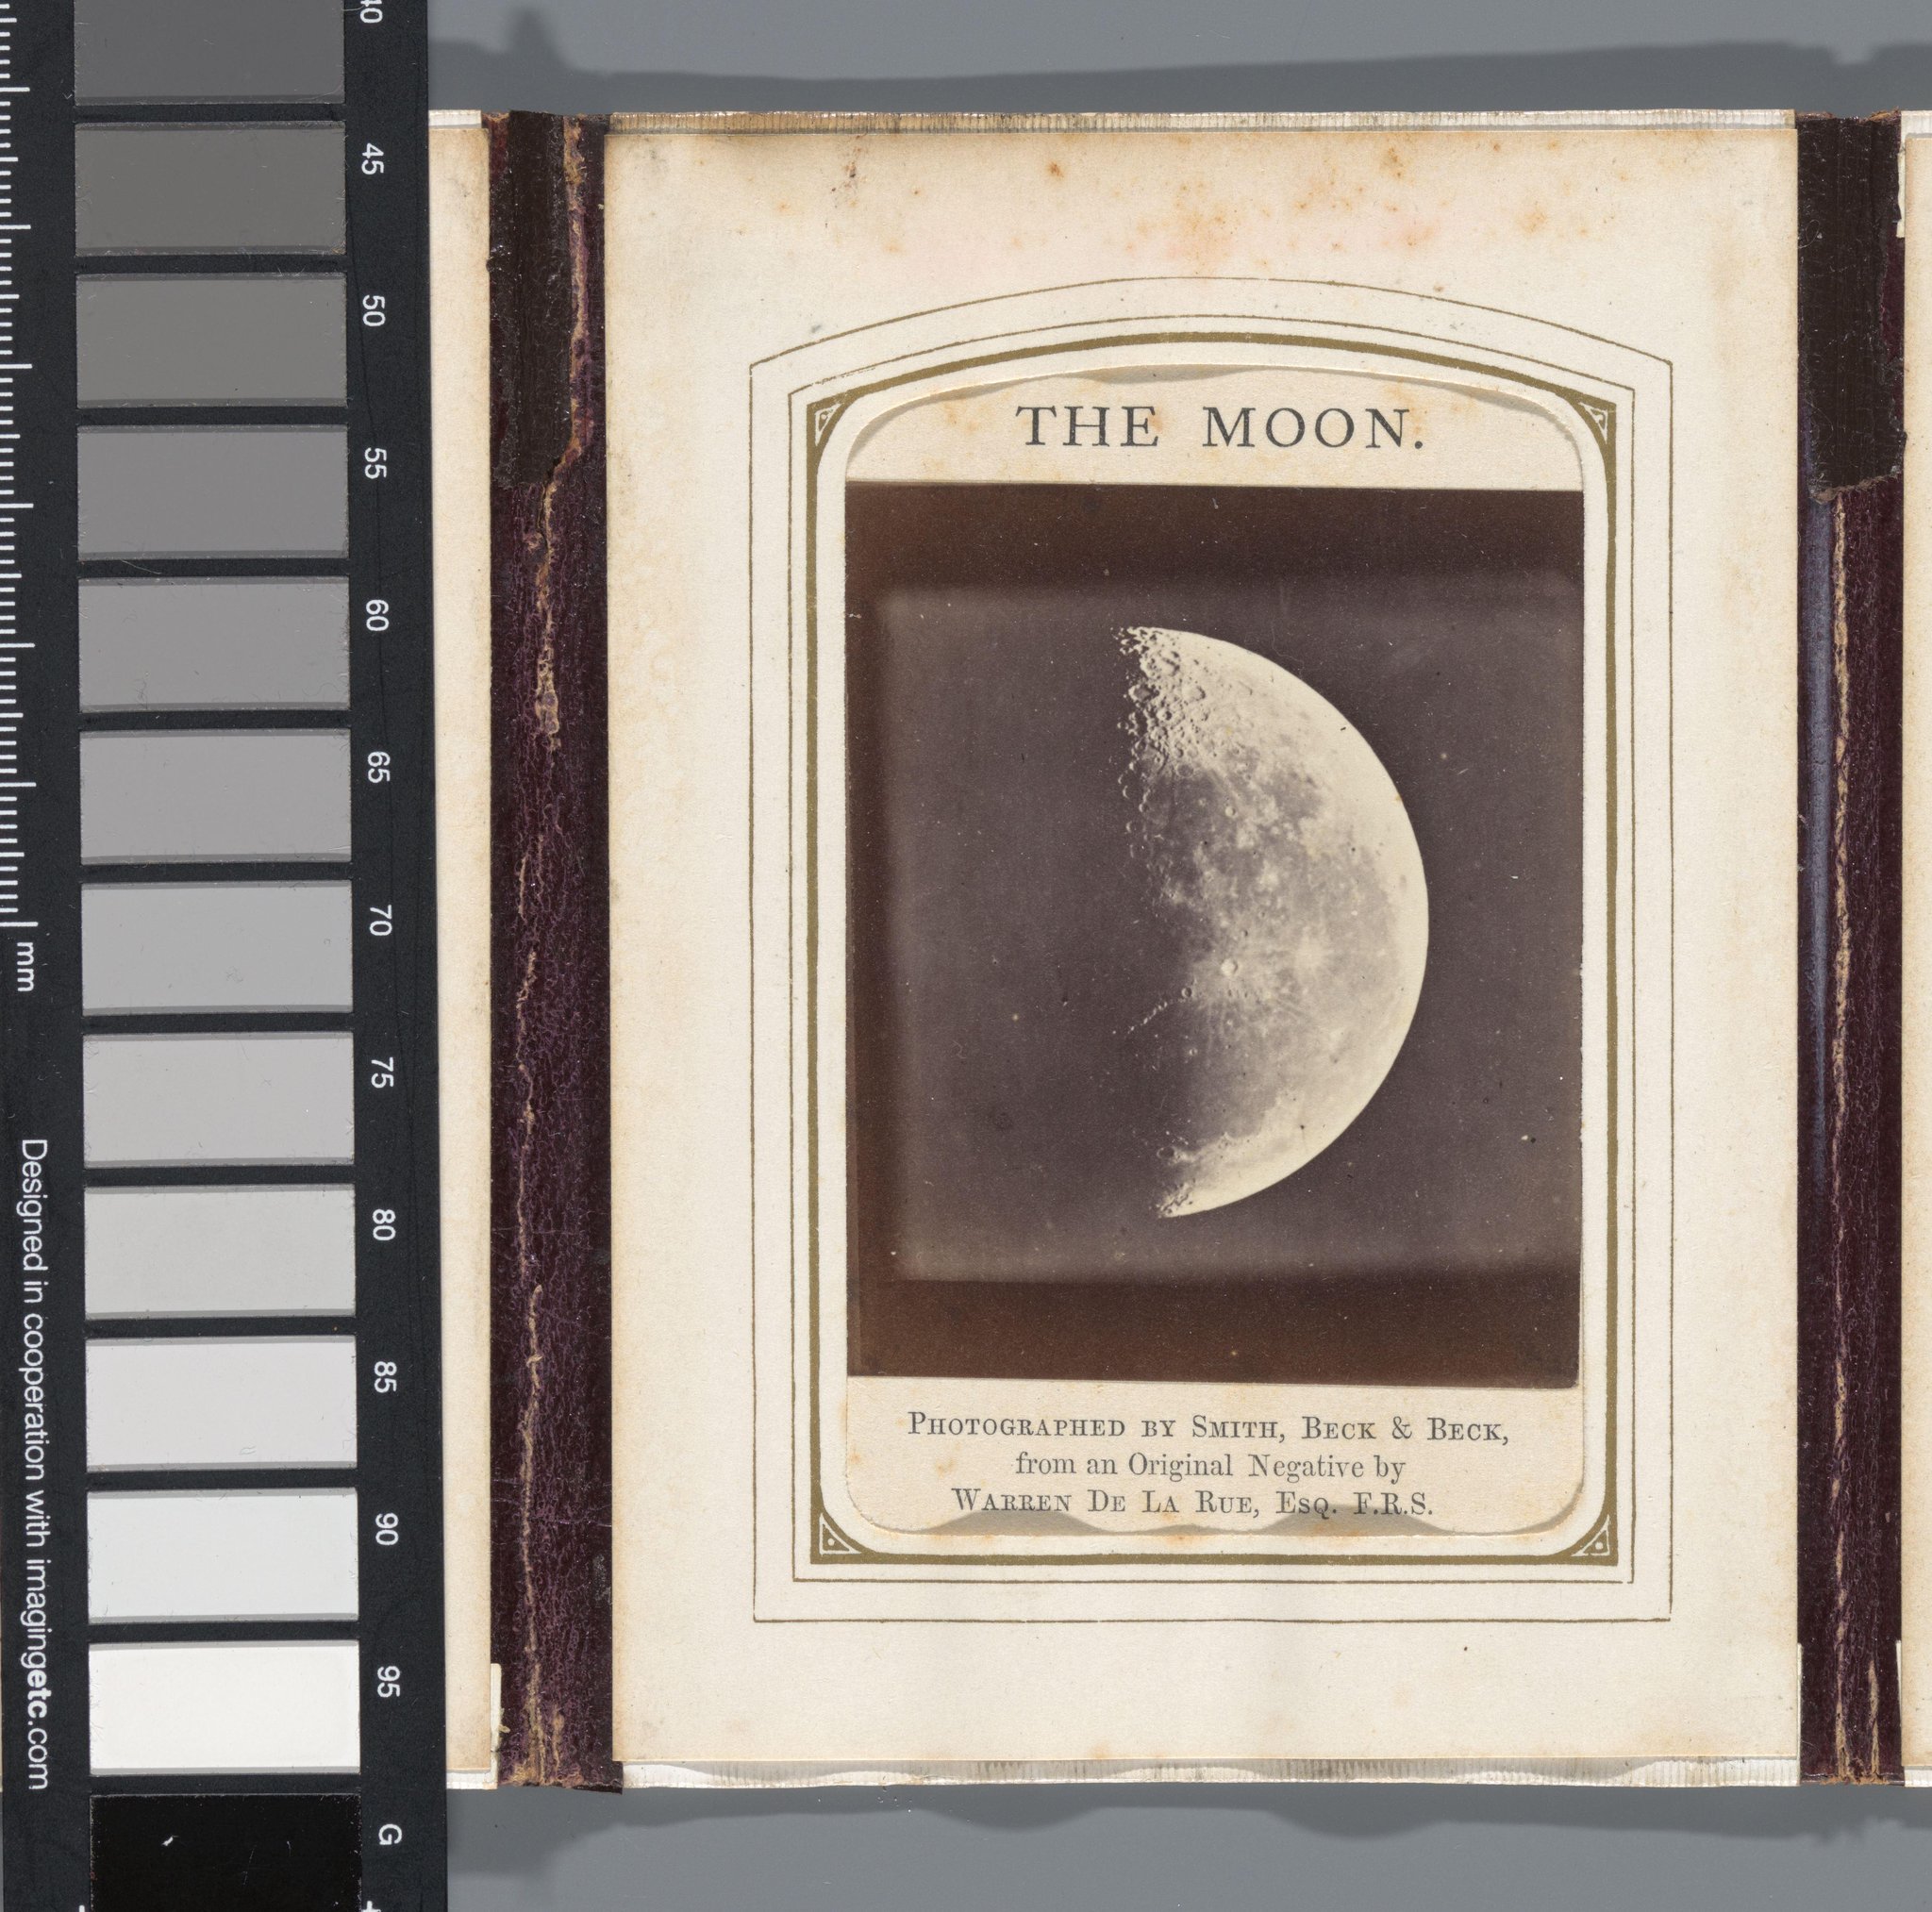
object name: photograph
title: Afnemende maan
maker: warren de la rue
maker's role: astronoom, fotograaf, scheikundige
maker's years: 1815-1889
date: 1866-1880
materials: cardboard, paper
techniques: albumen print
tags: waxing moon, i.e. facing this way: ), moon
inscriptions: inscription: ‘PHOTOGRAPHED BY SMITH, BECK & BECK,/ from an Original Negative by/WARREN DE LA RUE, ESQ, F.R.S.’